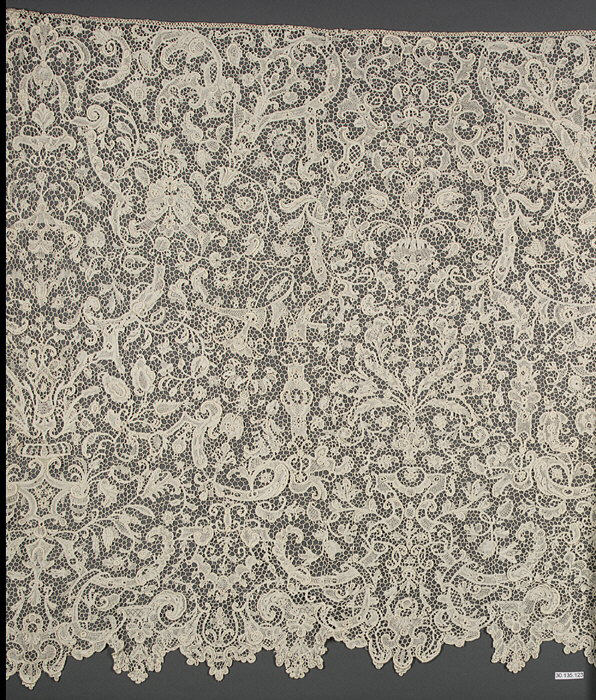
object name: flounce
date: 1667-1700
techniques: lace